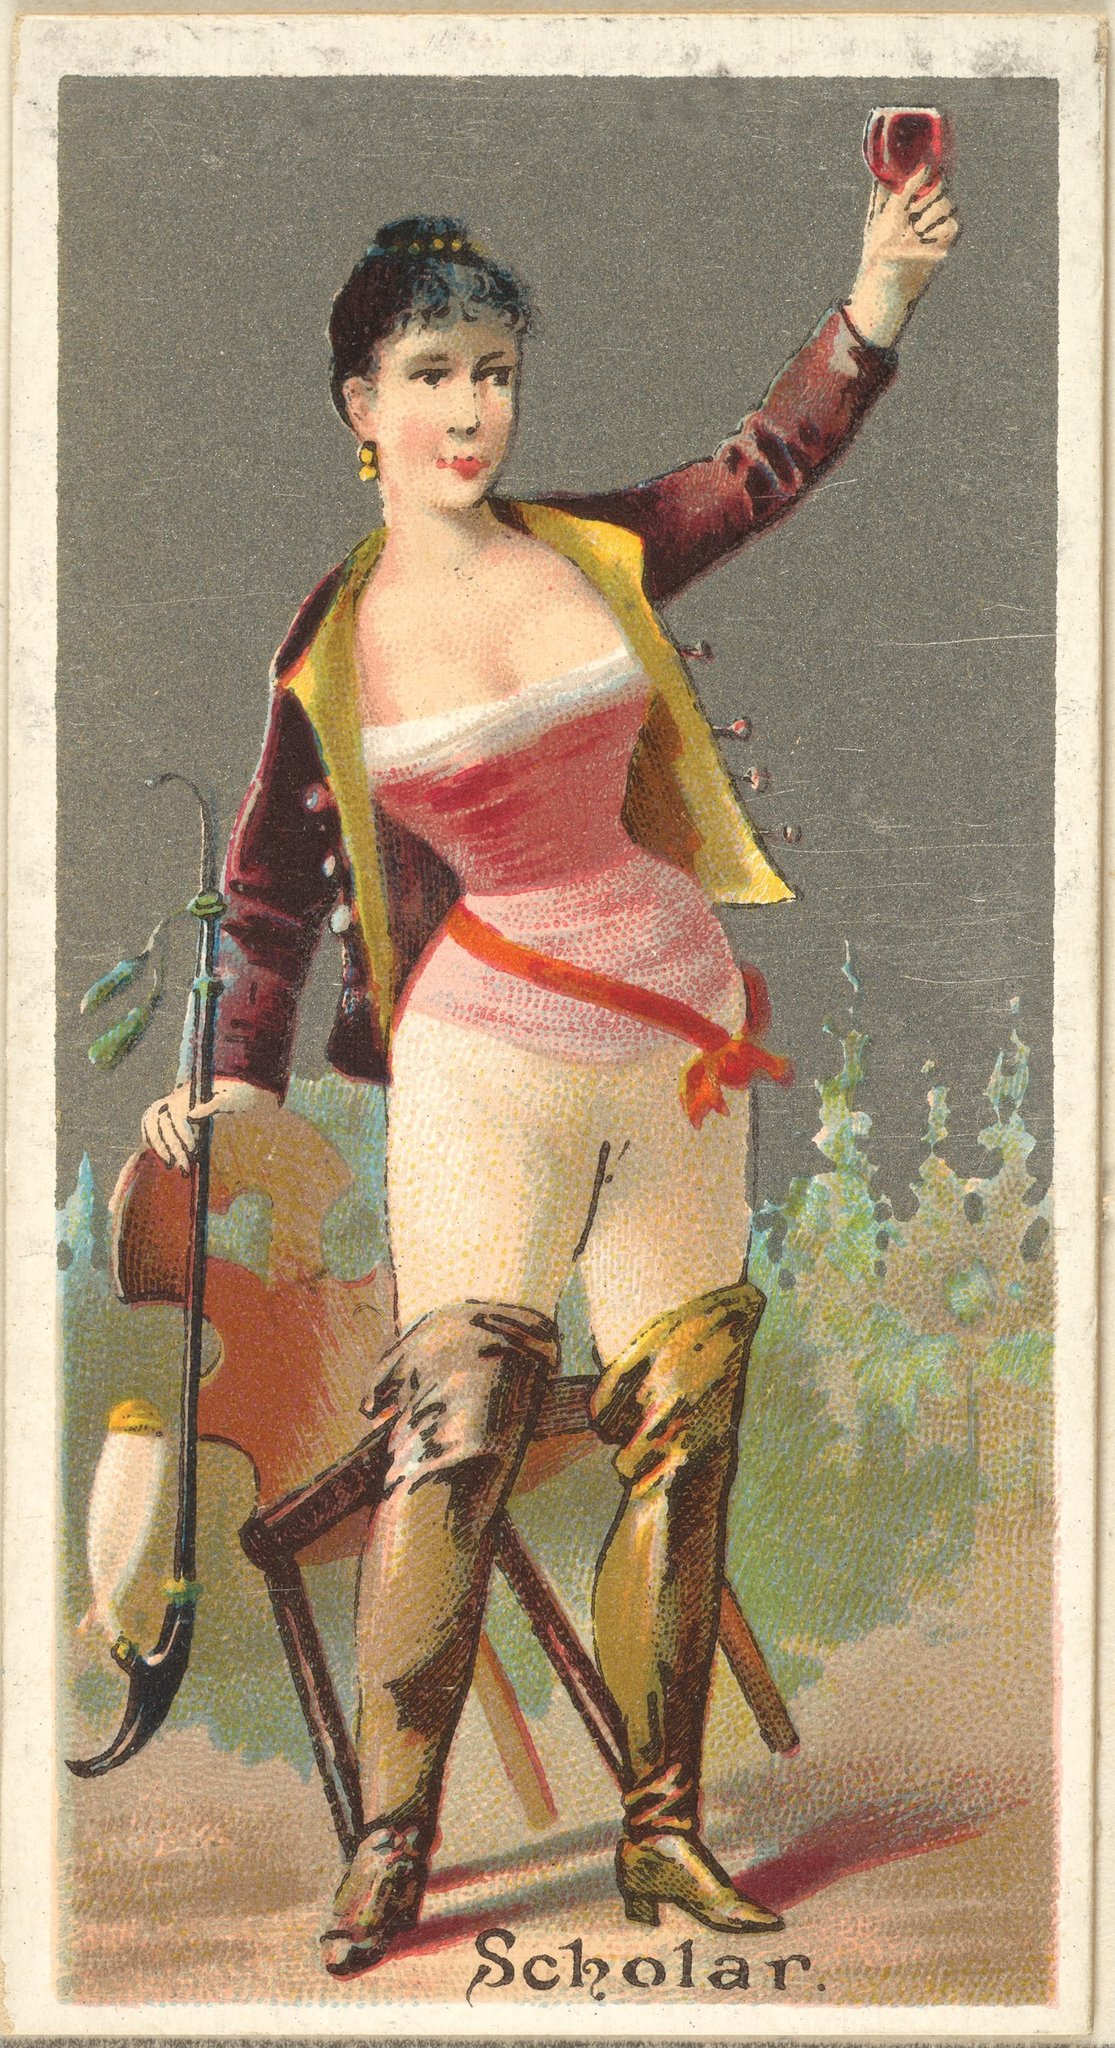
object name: print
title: Scholar, from the Occupations for Women series (N166) for Old Judge and Dogs Head Cigarettes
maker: goodwin & company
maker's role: publisher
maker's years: 1850-1950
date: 1887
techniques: color lithograph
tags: women